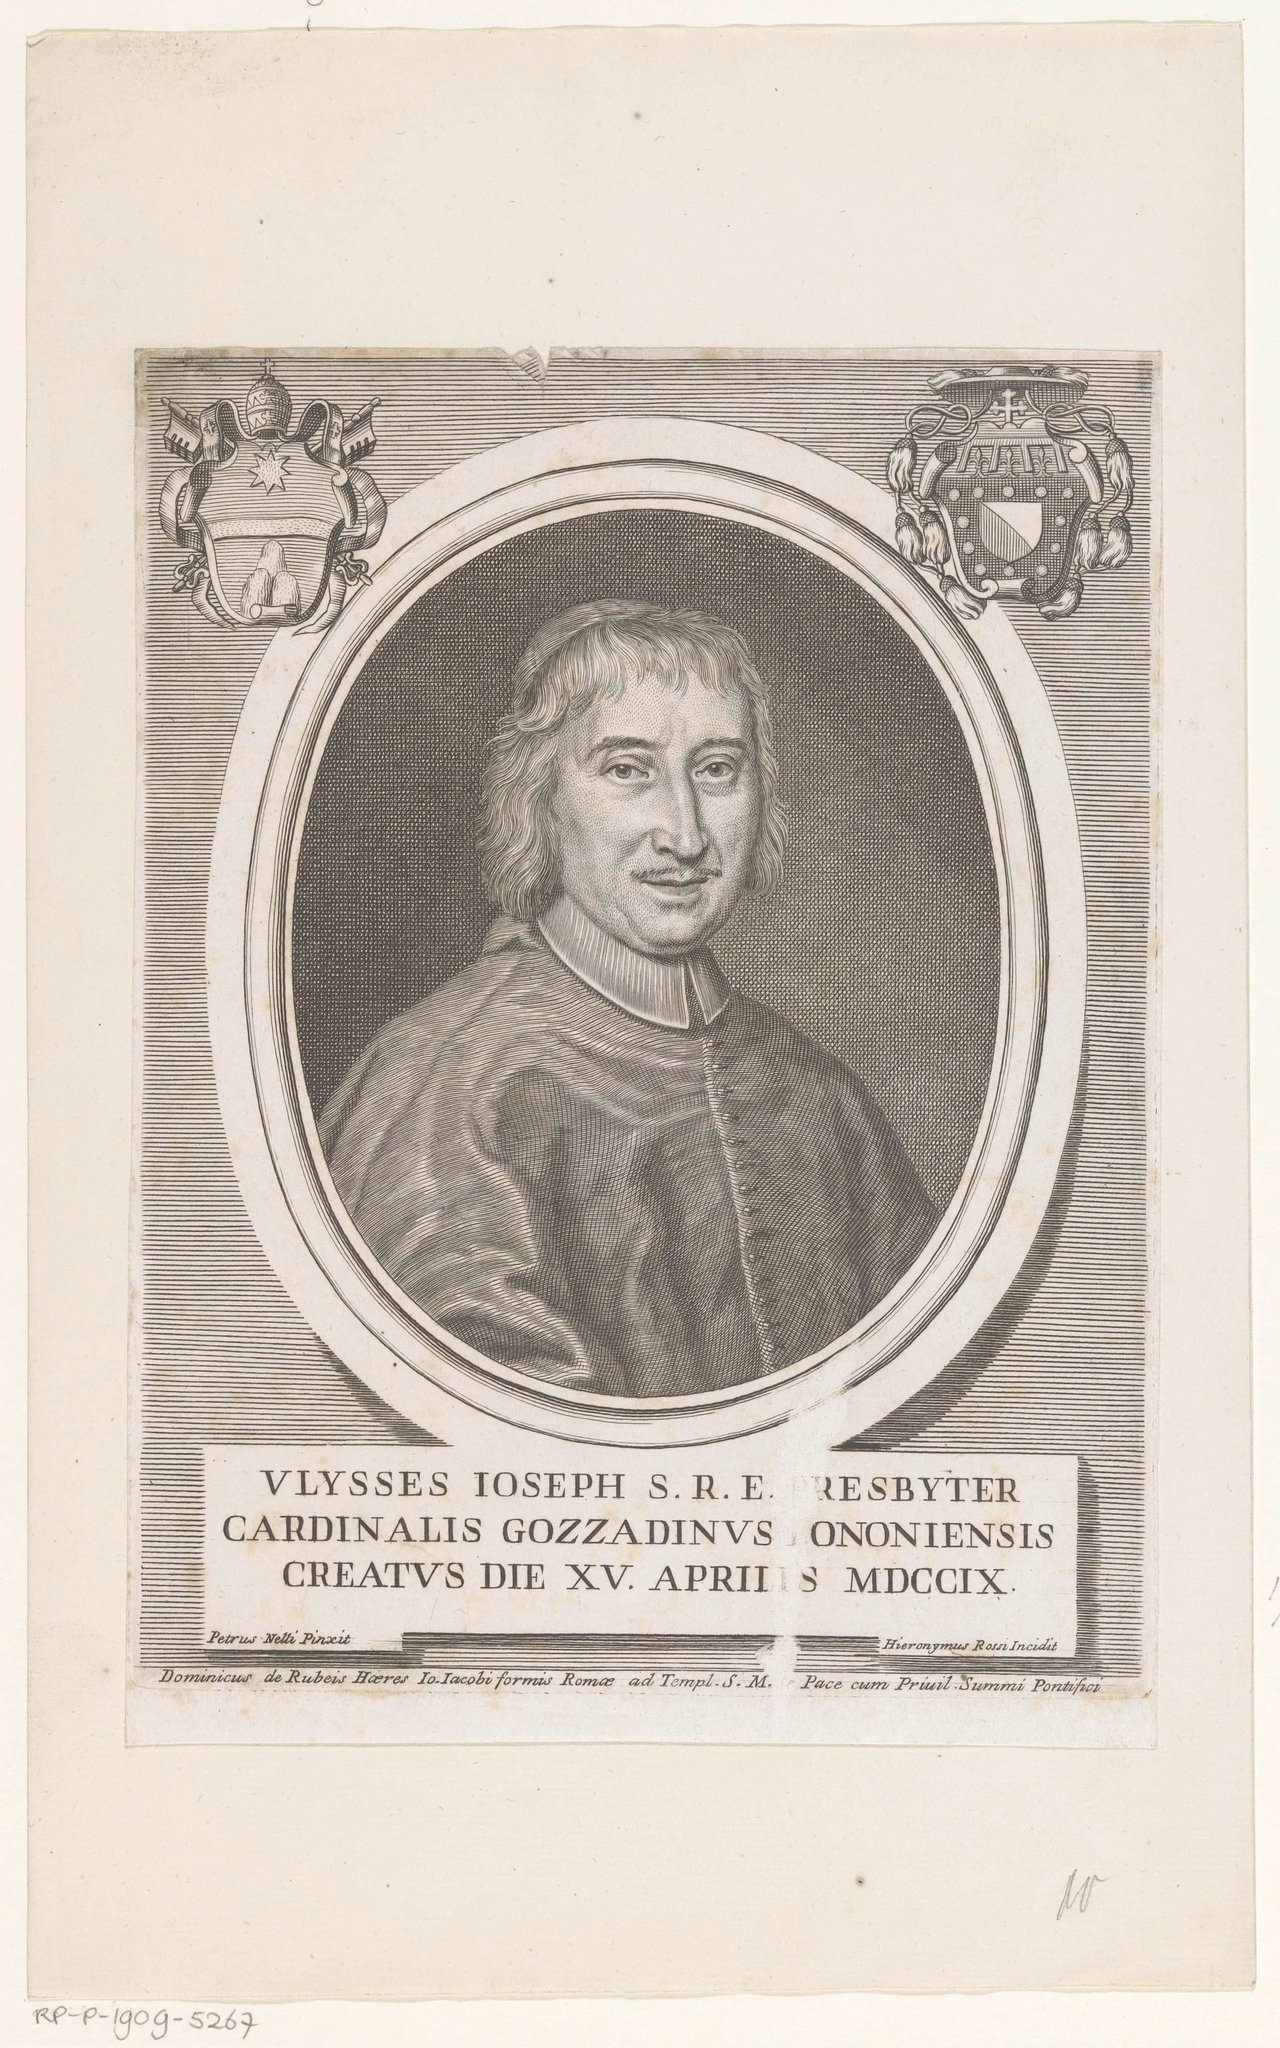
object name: print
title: Portret van kardinaal Ulisse Giuseppe Gozzadini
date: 1709-1762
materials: paper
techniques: engraving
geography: rome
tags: italy, cardinal, historical persons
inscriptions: collector's mark: Lugt 2228